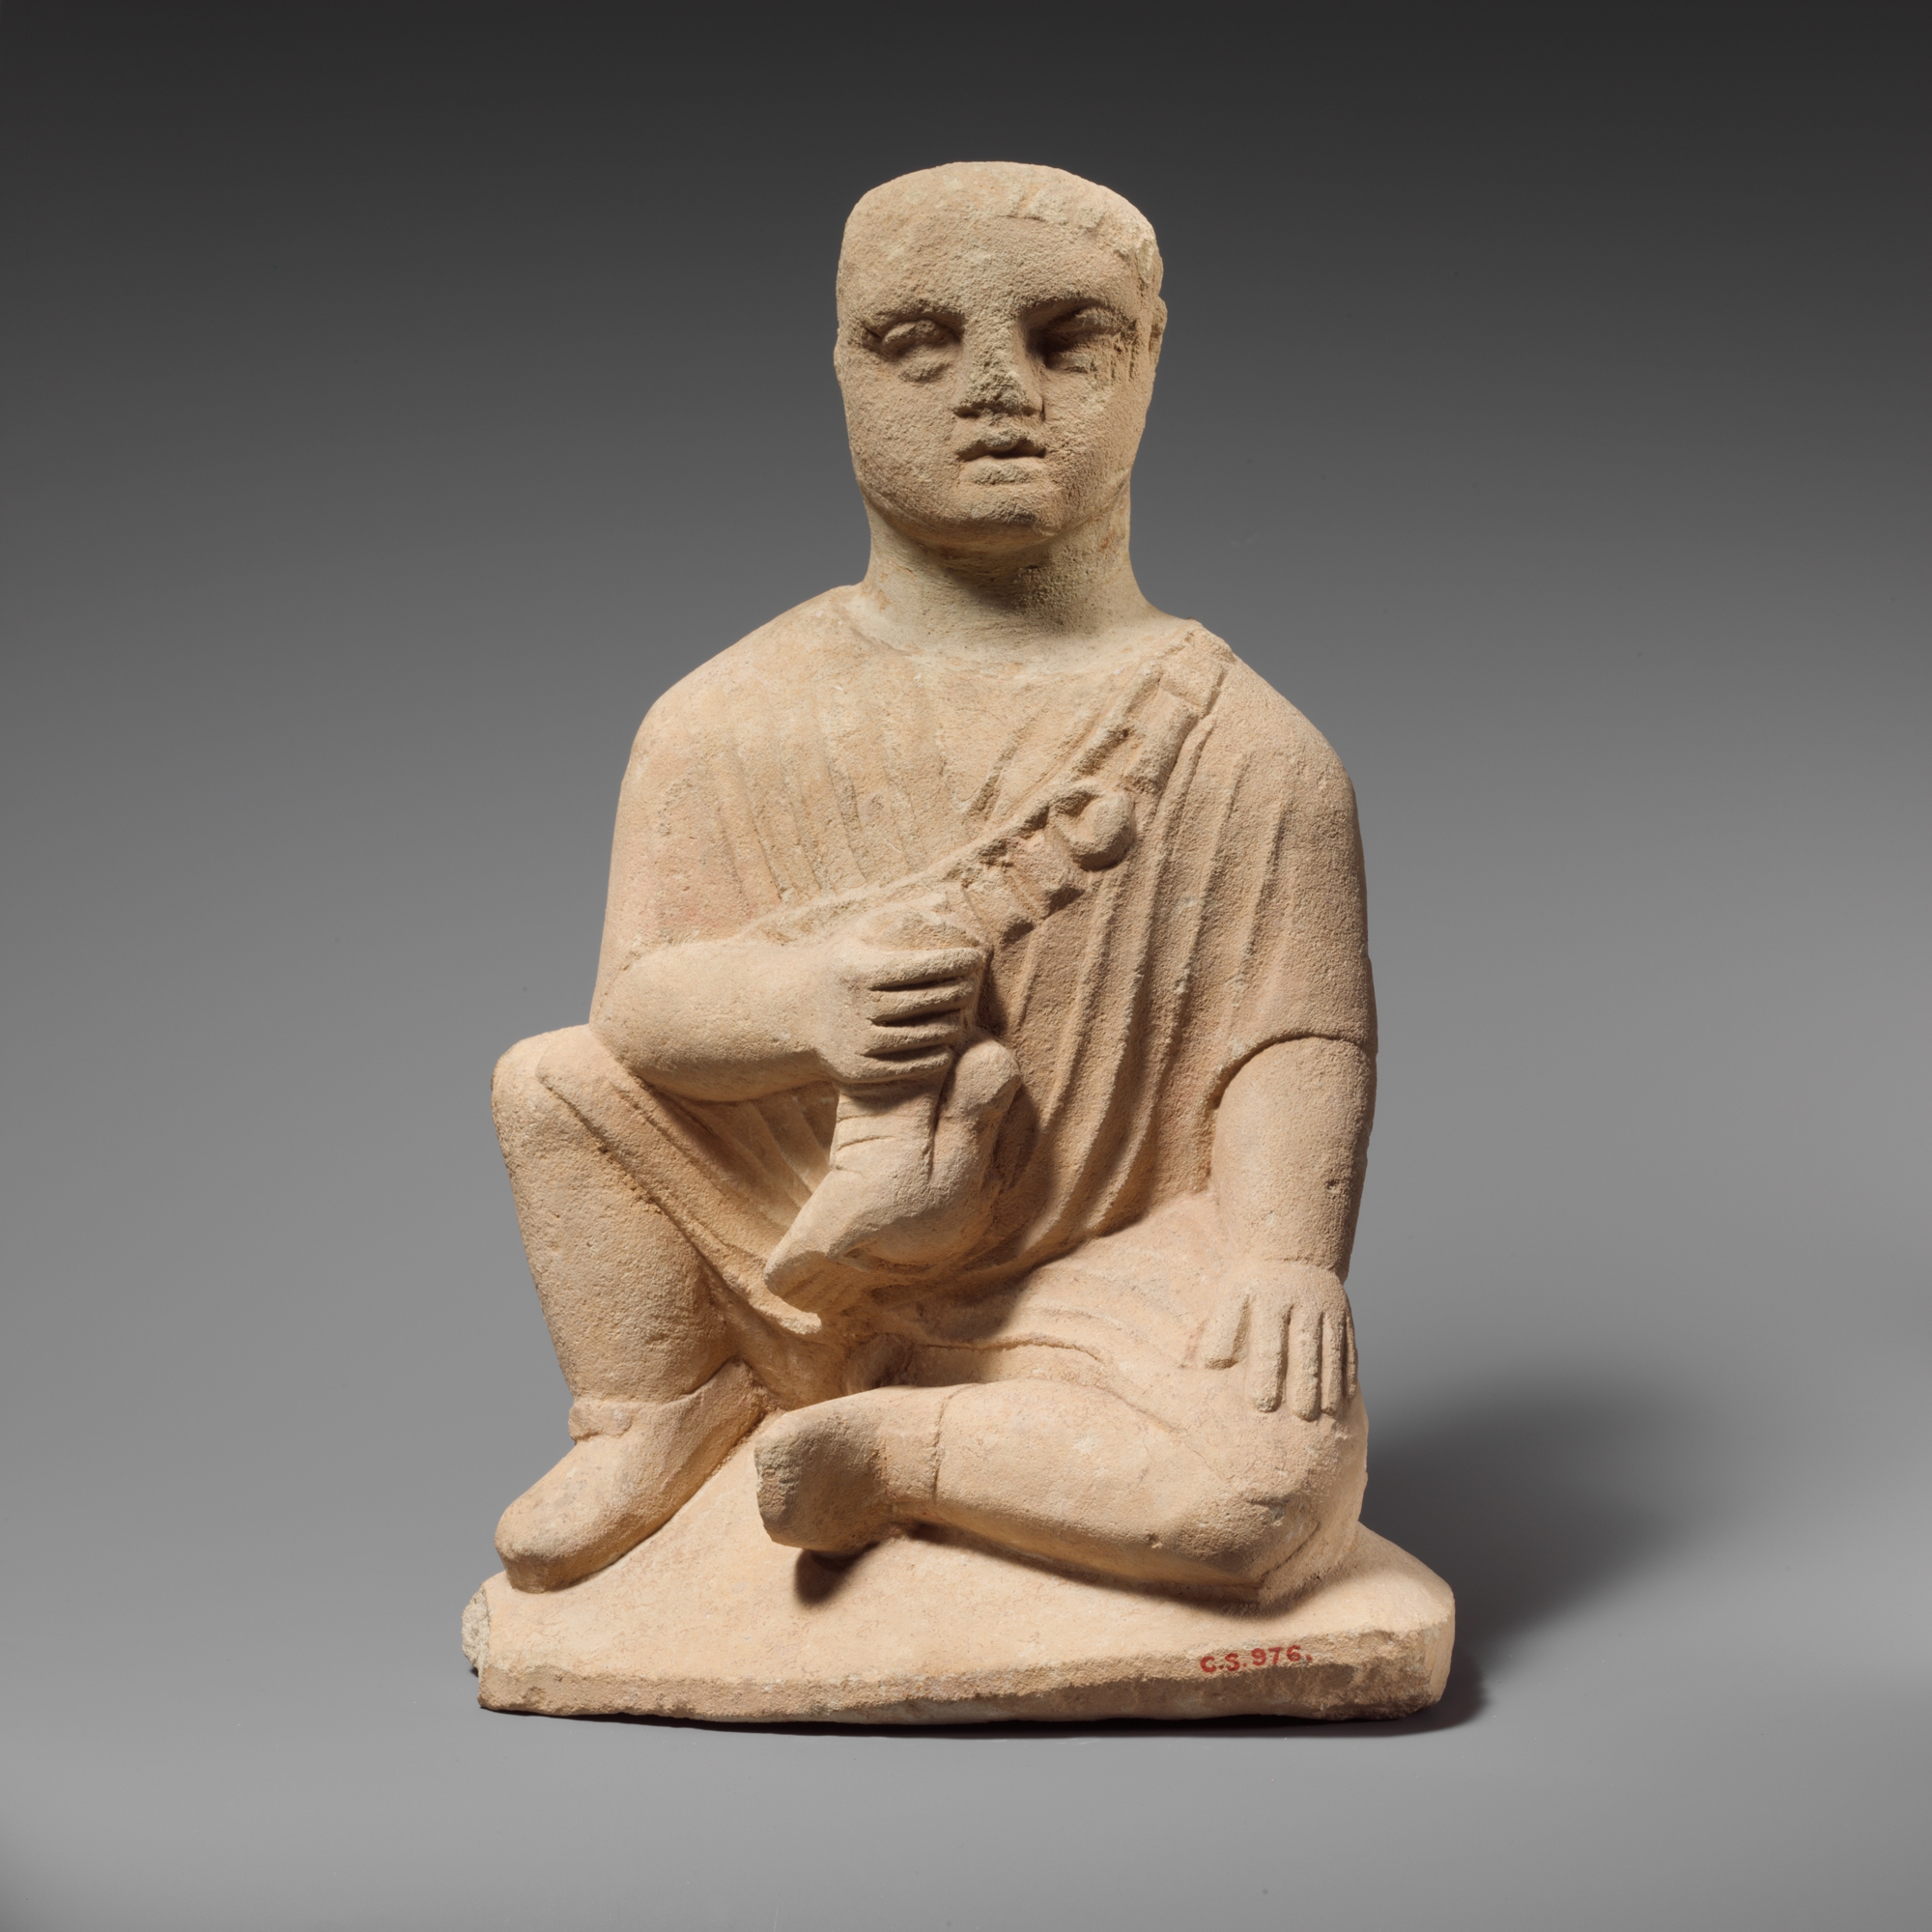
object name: statuette of a temple boy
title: Limestone statuette of a temple boy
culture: cypriot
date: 400-201 BCE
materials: limestone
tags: doves,boys